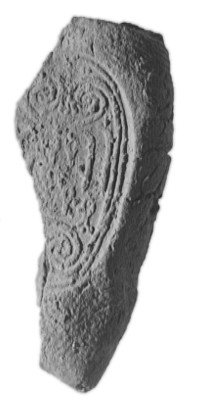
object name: sealing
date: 2030-1640 BCE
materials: clay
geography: egypt